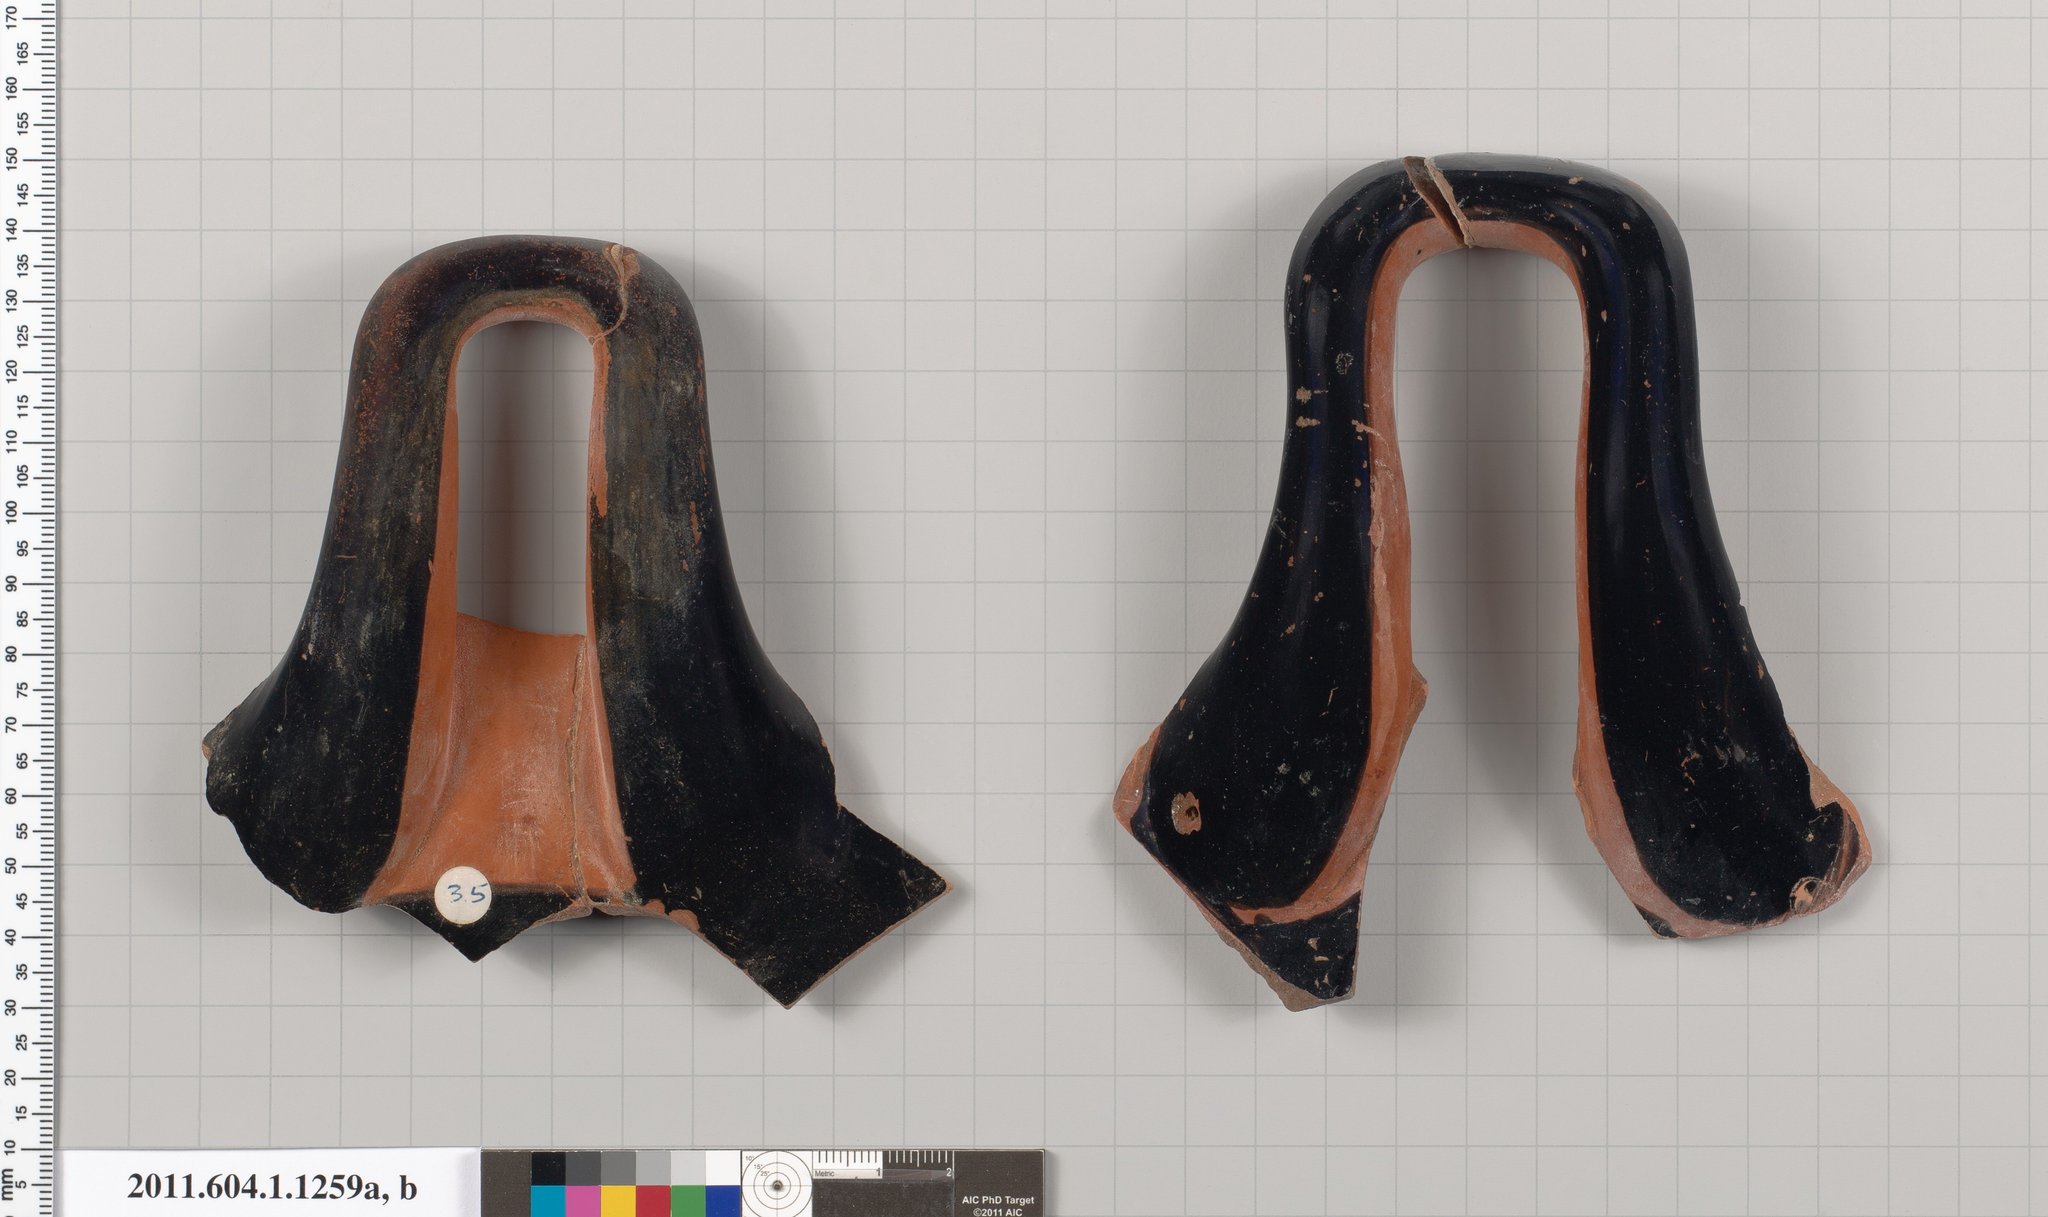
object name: kylix fragment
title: Terracotta fragments of kylikes (drinking cups)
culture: greek, attic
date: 500-401 BCE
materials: terracotta